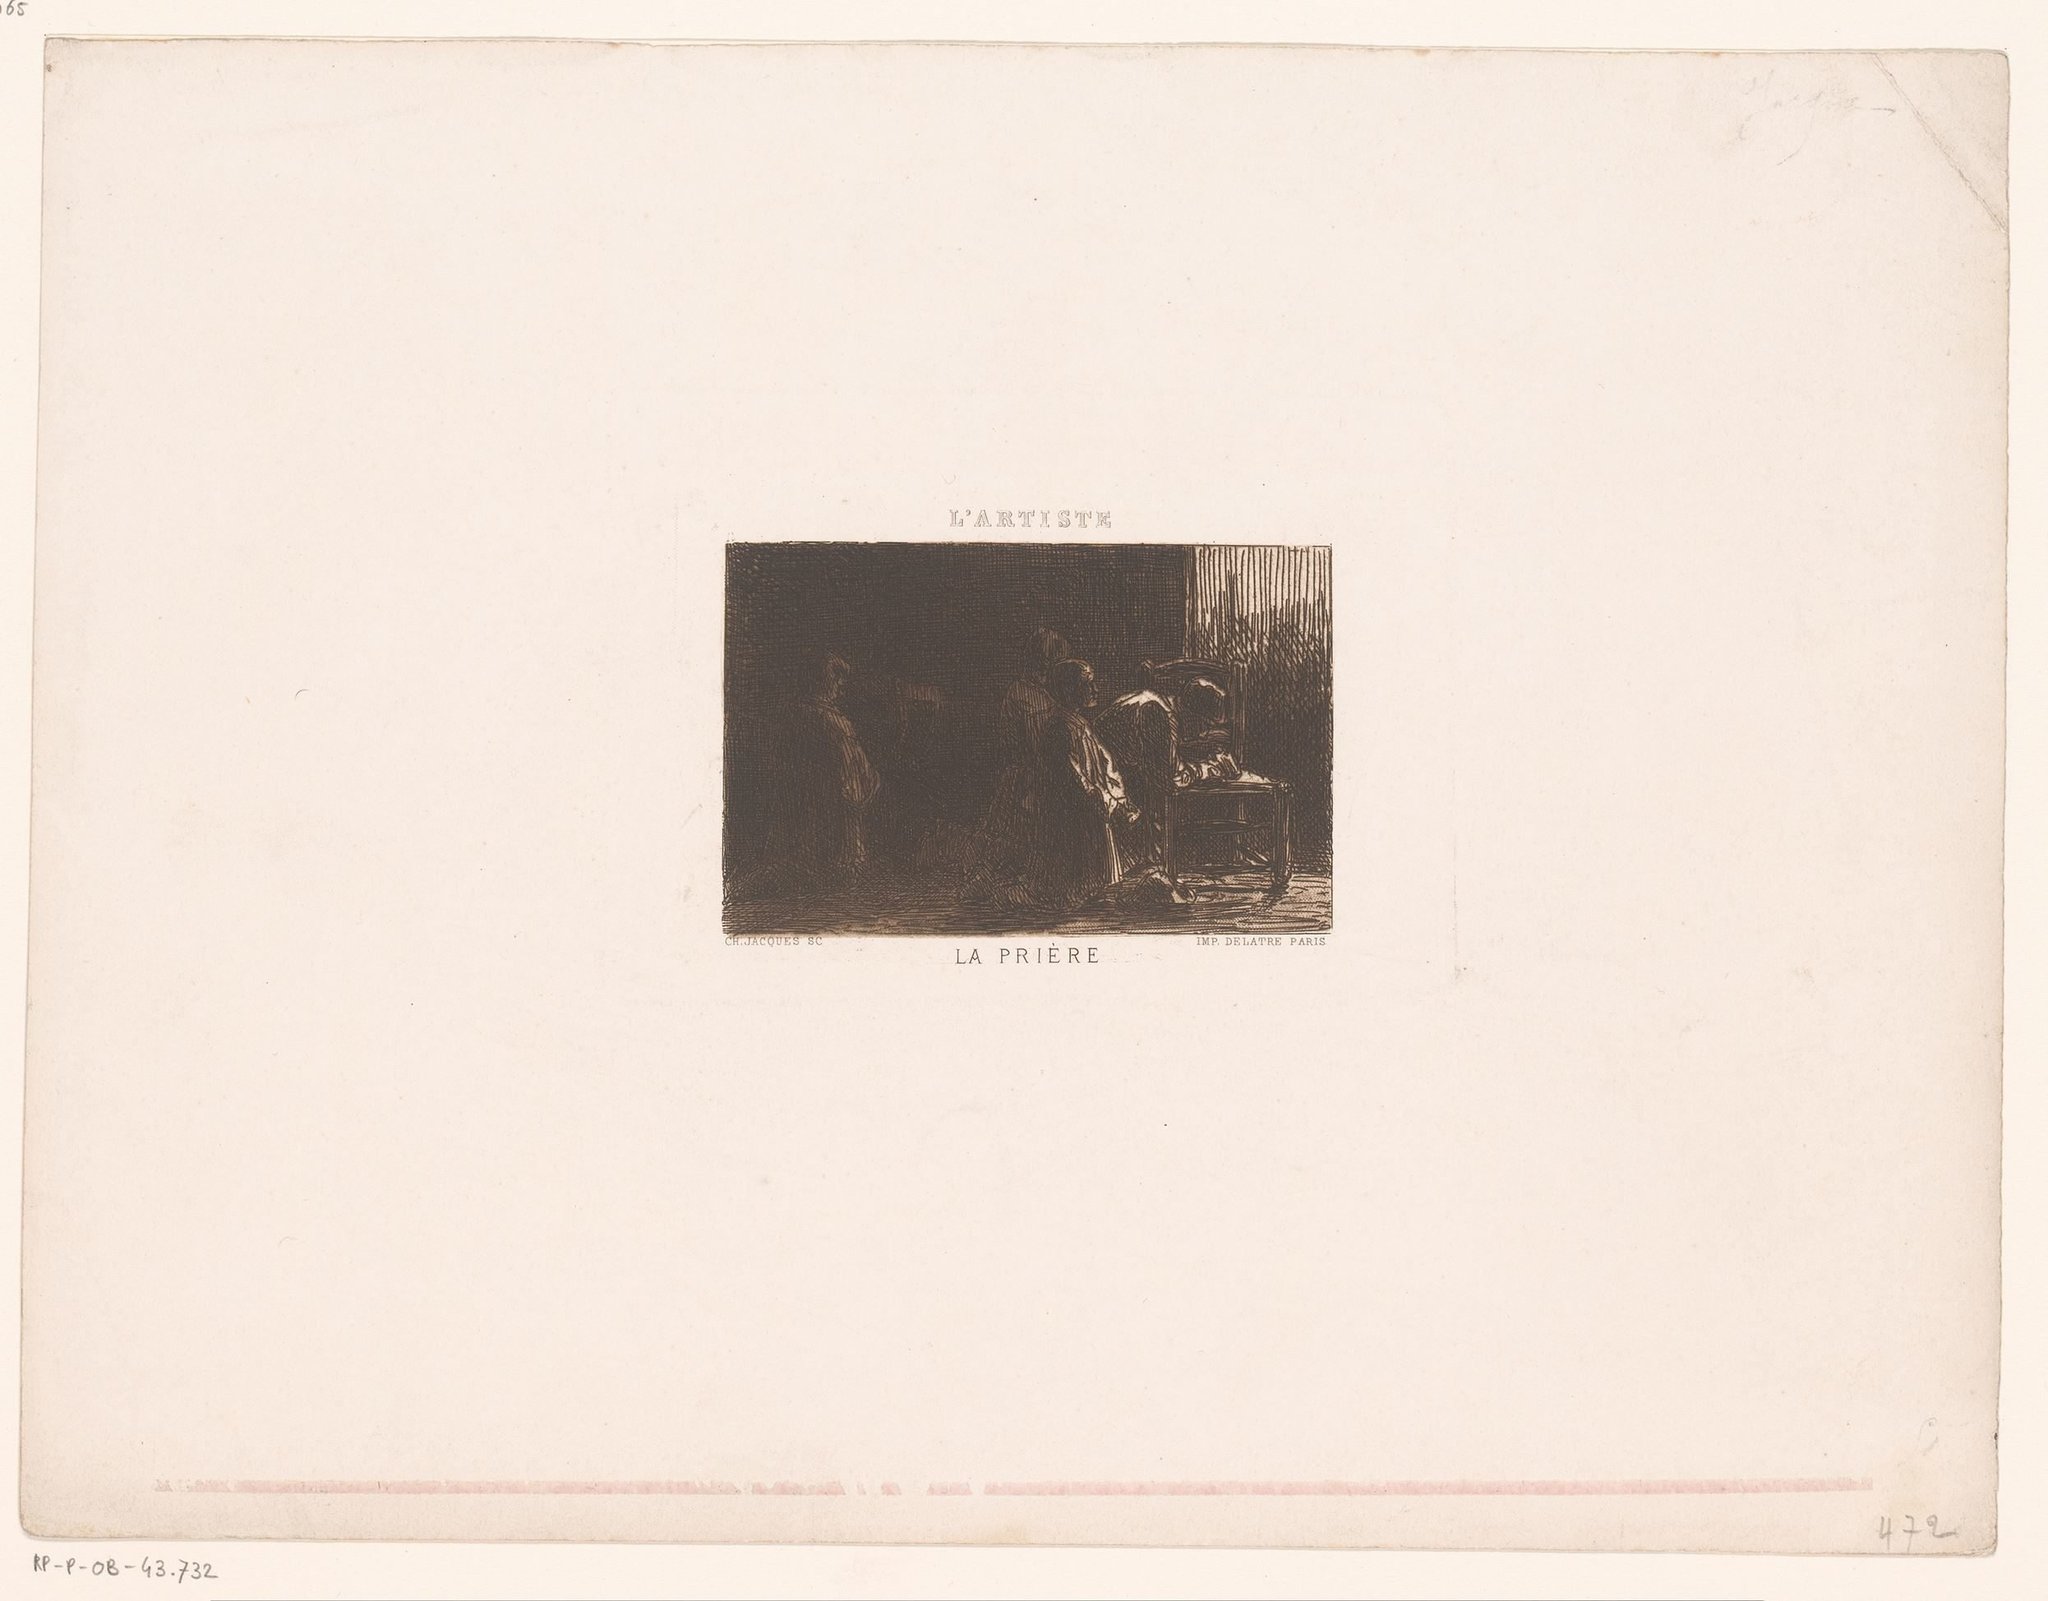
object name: print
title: La Prière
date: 1843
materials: paper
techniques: etching, roulette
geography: paris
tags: family group, especially parents with their child(ren), (private) prayer; 'oratione', 'preghiere', 'preghiere a dio' (ripa)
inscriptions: collector's mark: Lugt 2228